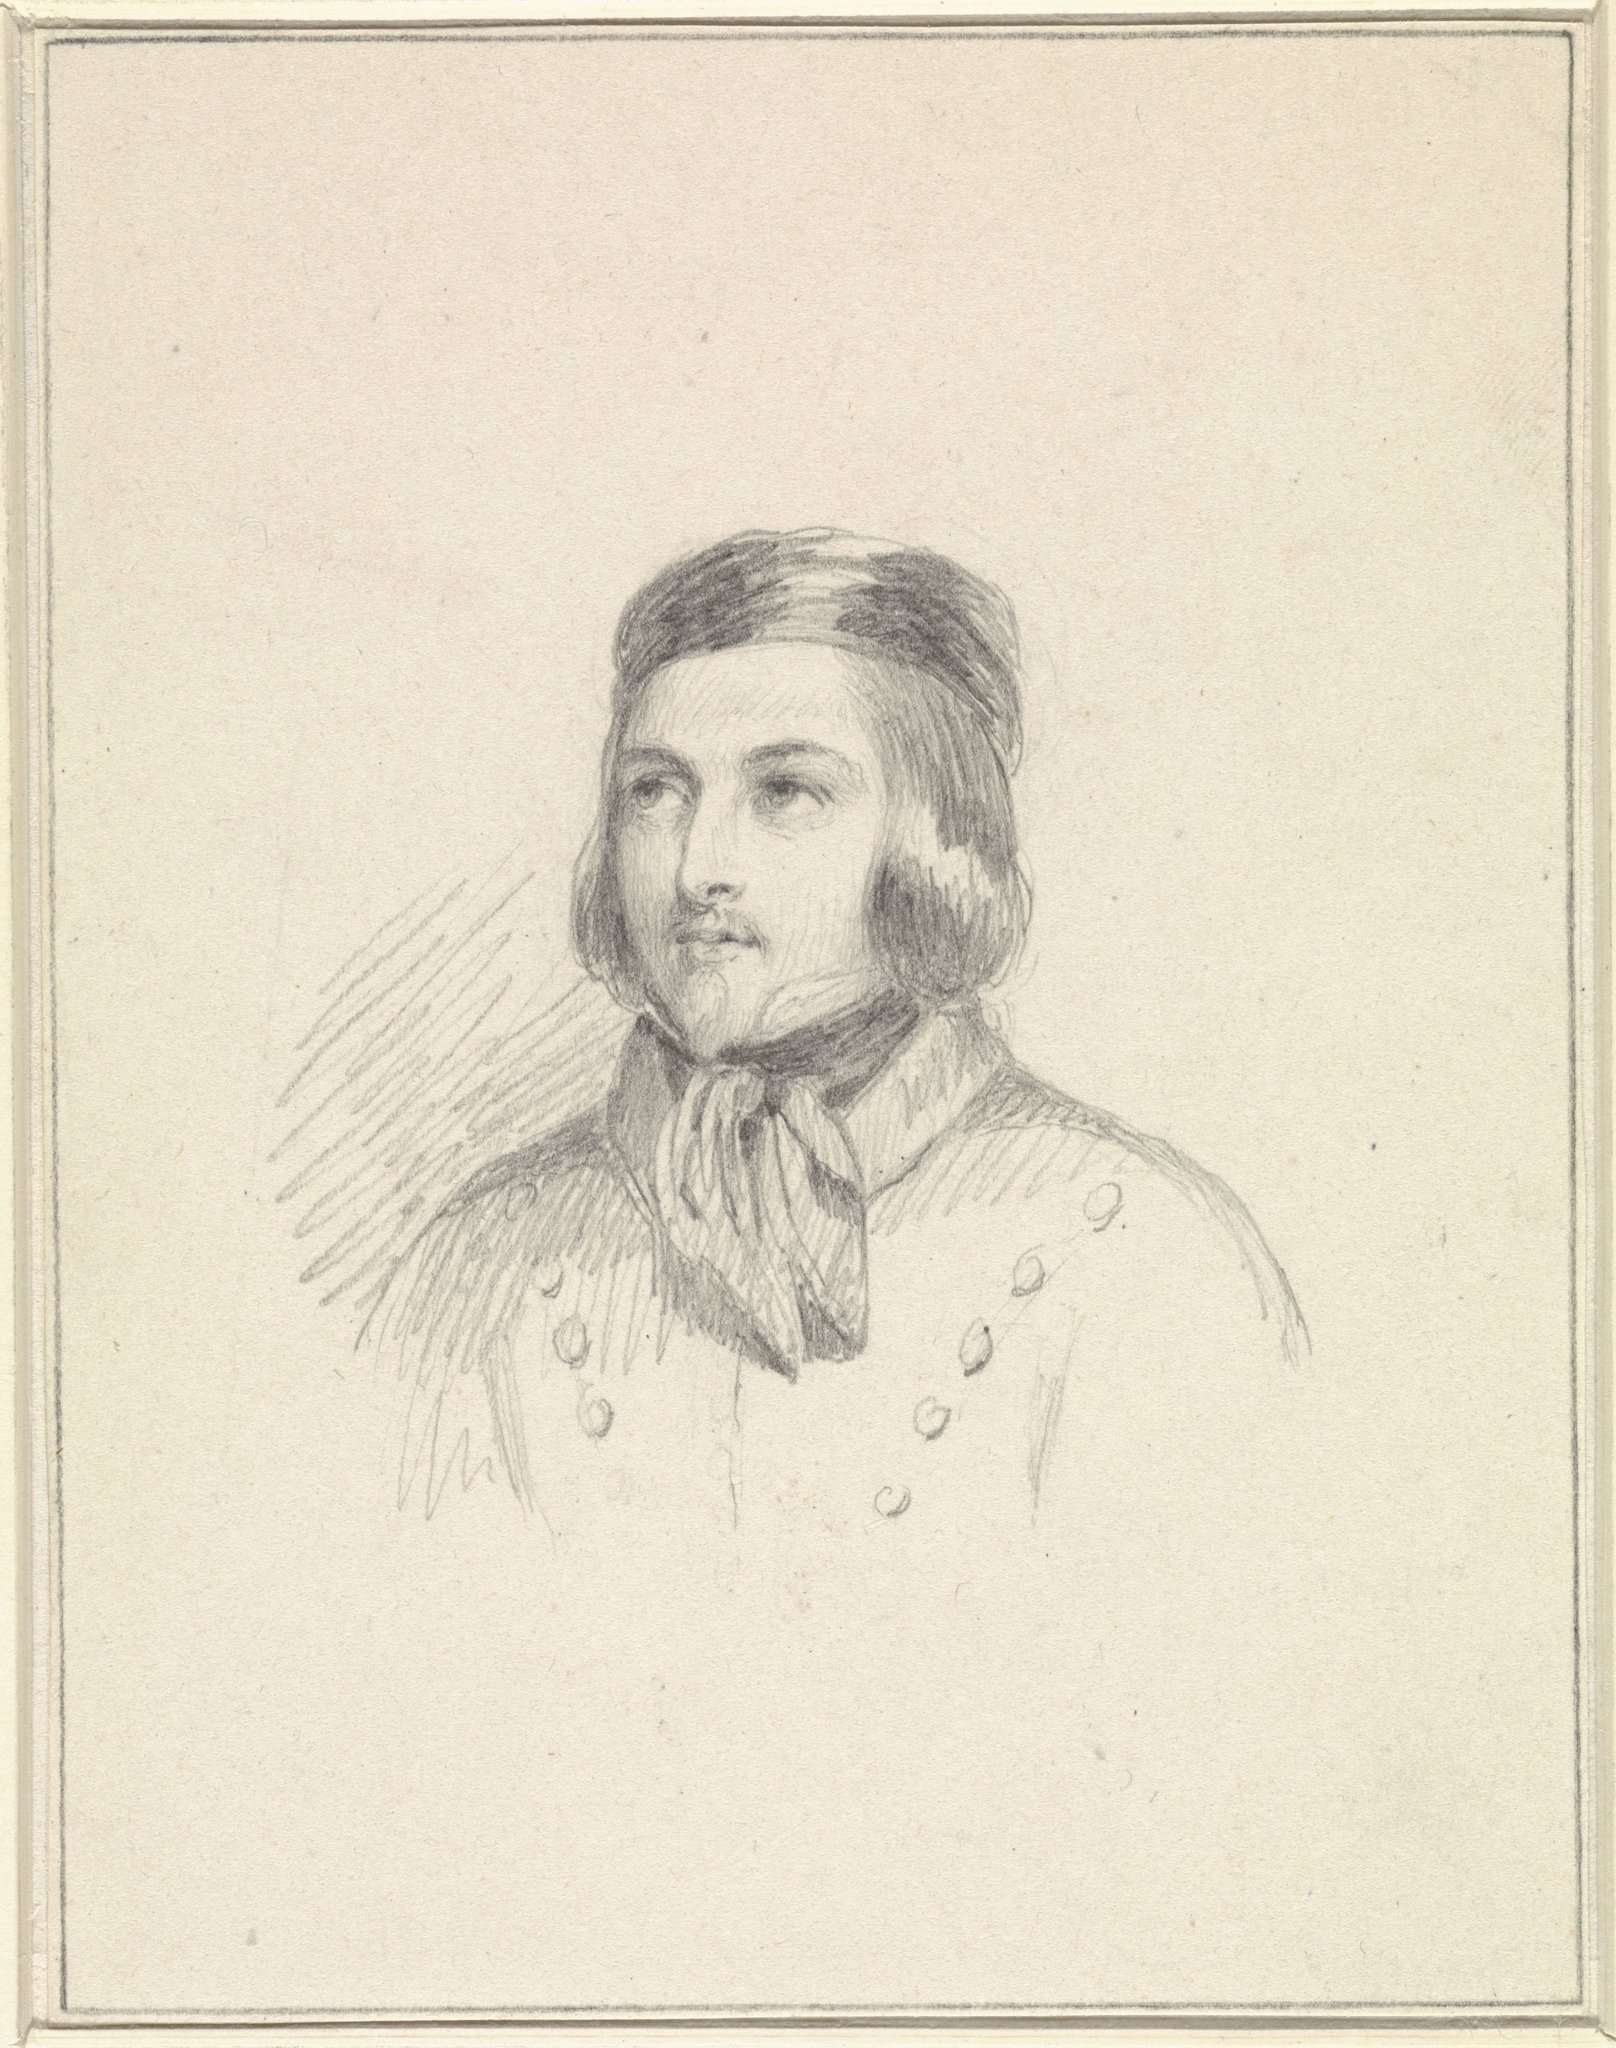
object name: design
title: Portret van Aloysius Geefs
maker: Anonymous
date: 1841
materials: paper, pencil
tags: antwerp, painter, aloysius geefs, historical persons, portrait, self-portrait of painter, portrait, self-portrait of artist, portrait, self-portrait of draughtsman